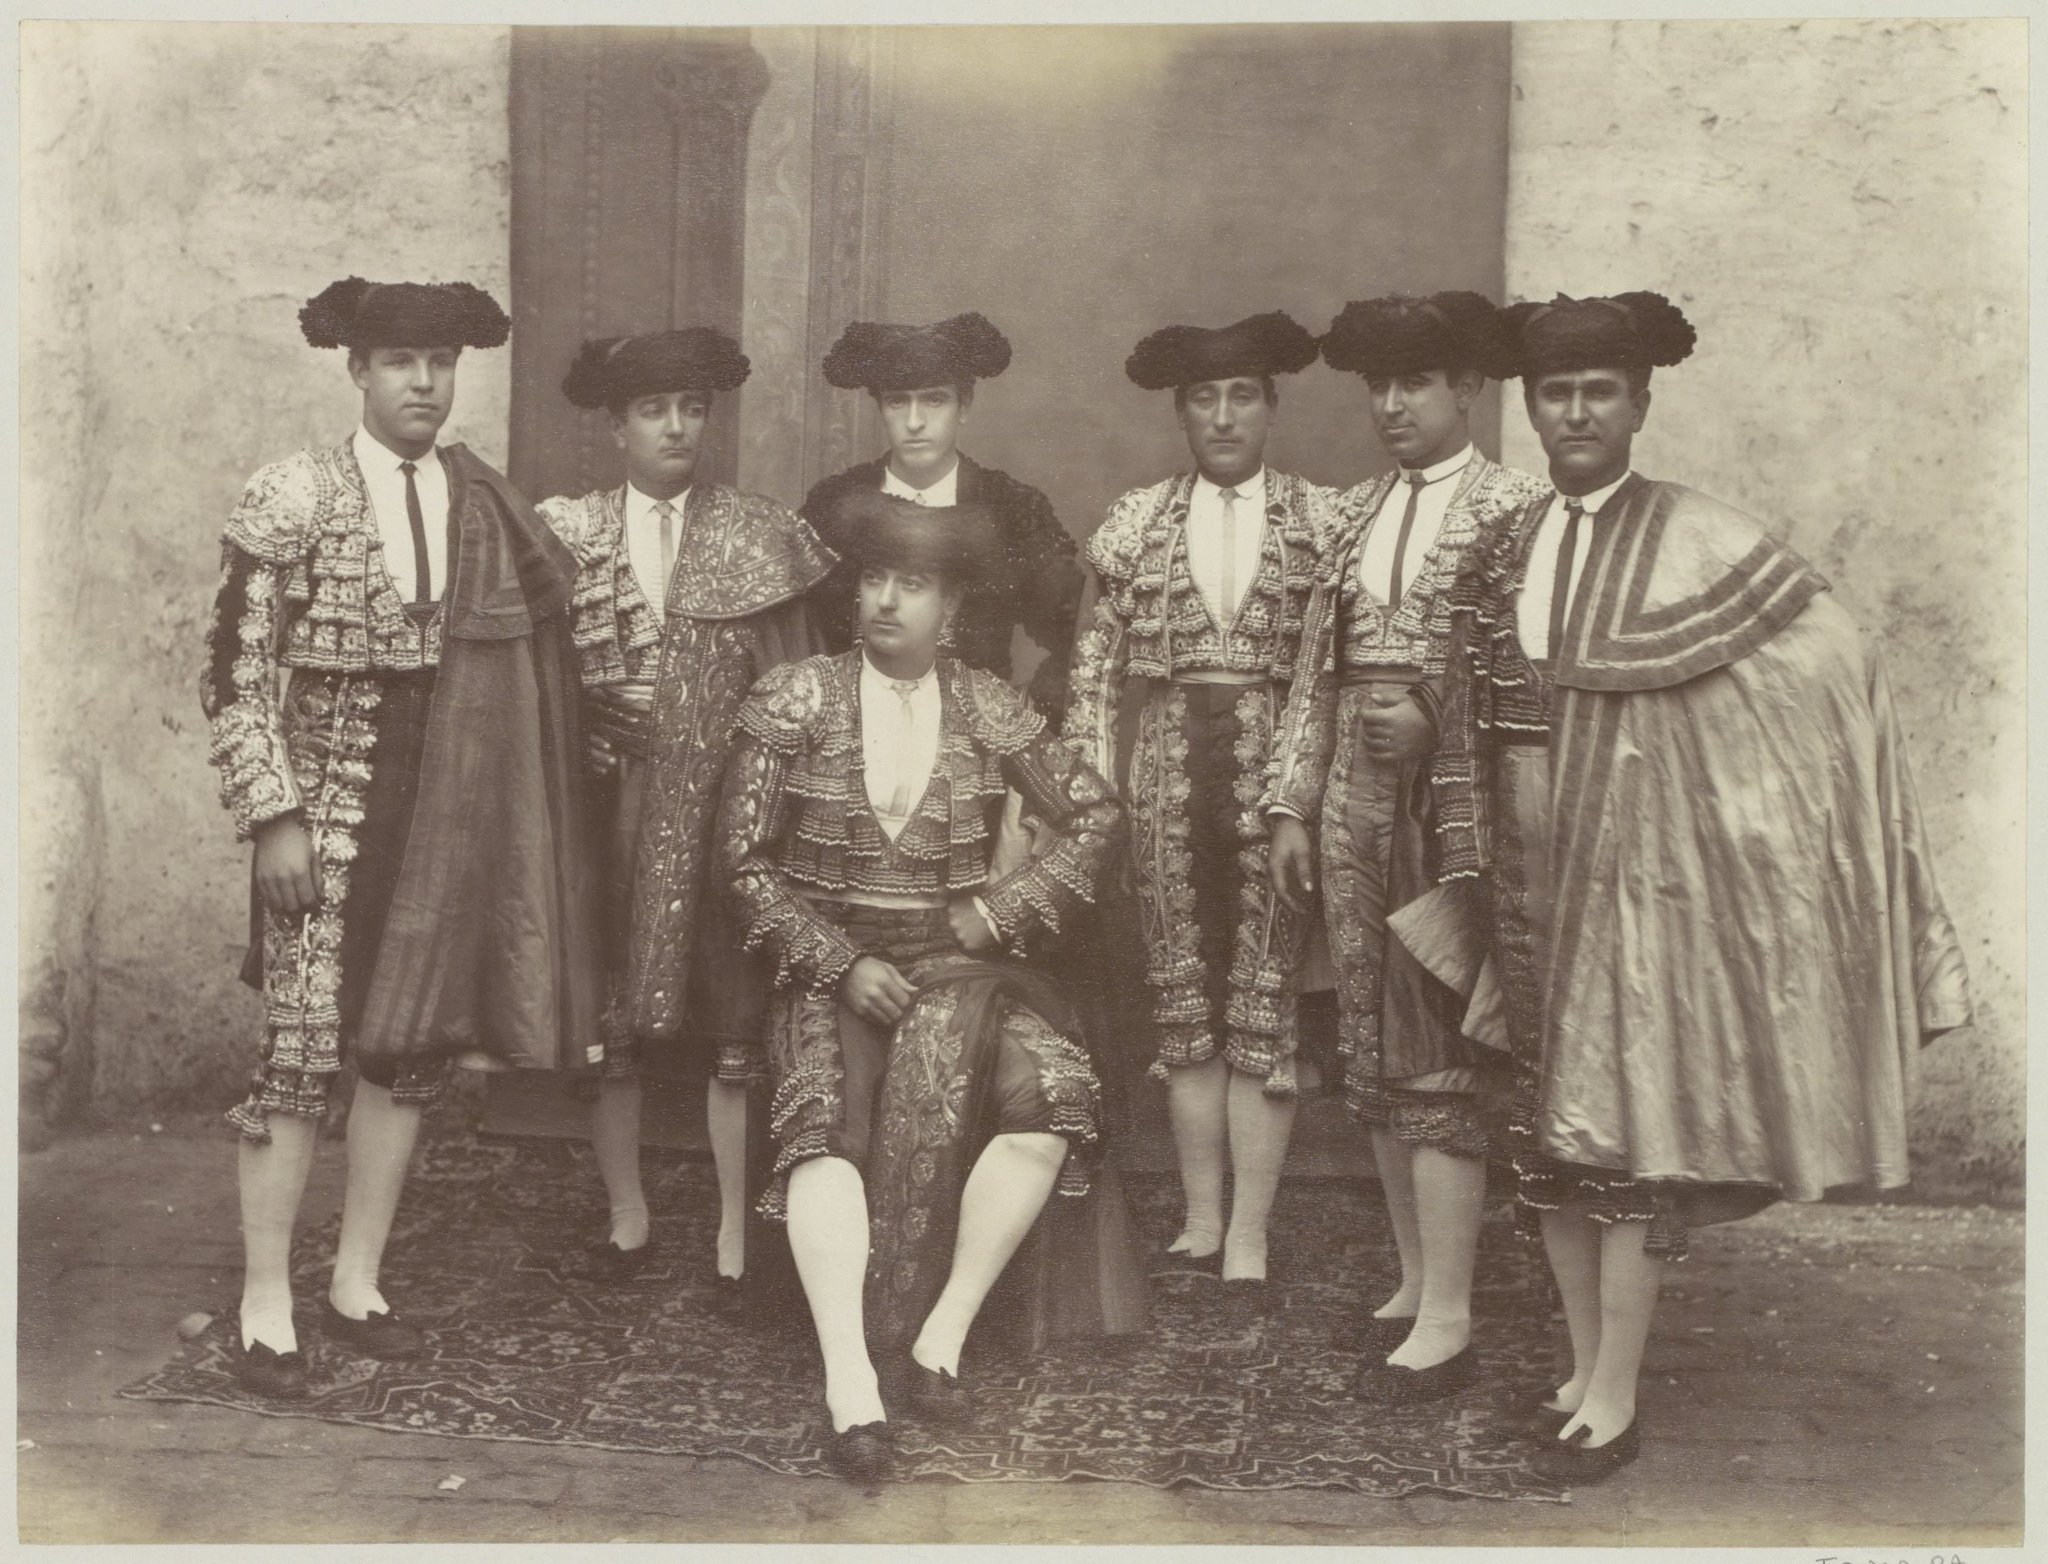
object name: photograph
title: Groepsportret van zeven stierenvechters, vermoedelijk in Spanje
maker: Anonymous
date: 1860-1880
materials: cardboard, paper, photographic support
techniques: albumen print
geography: spain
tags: bull-fighter, toreador, spain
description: Onderdeel van Reisalbum met foto's van bezienswaardigheden in Spanje en Marokko.